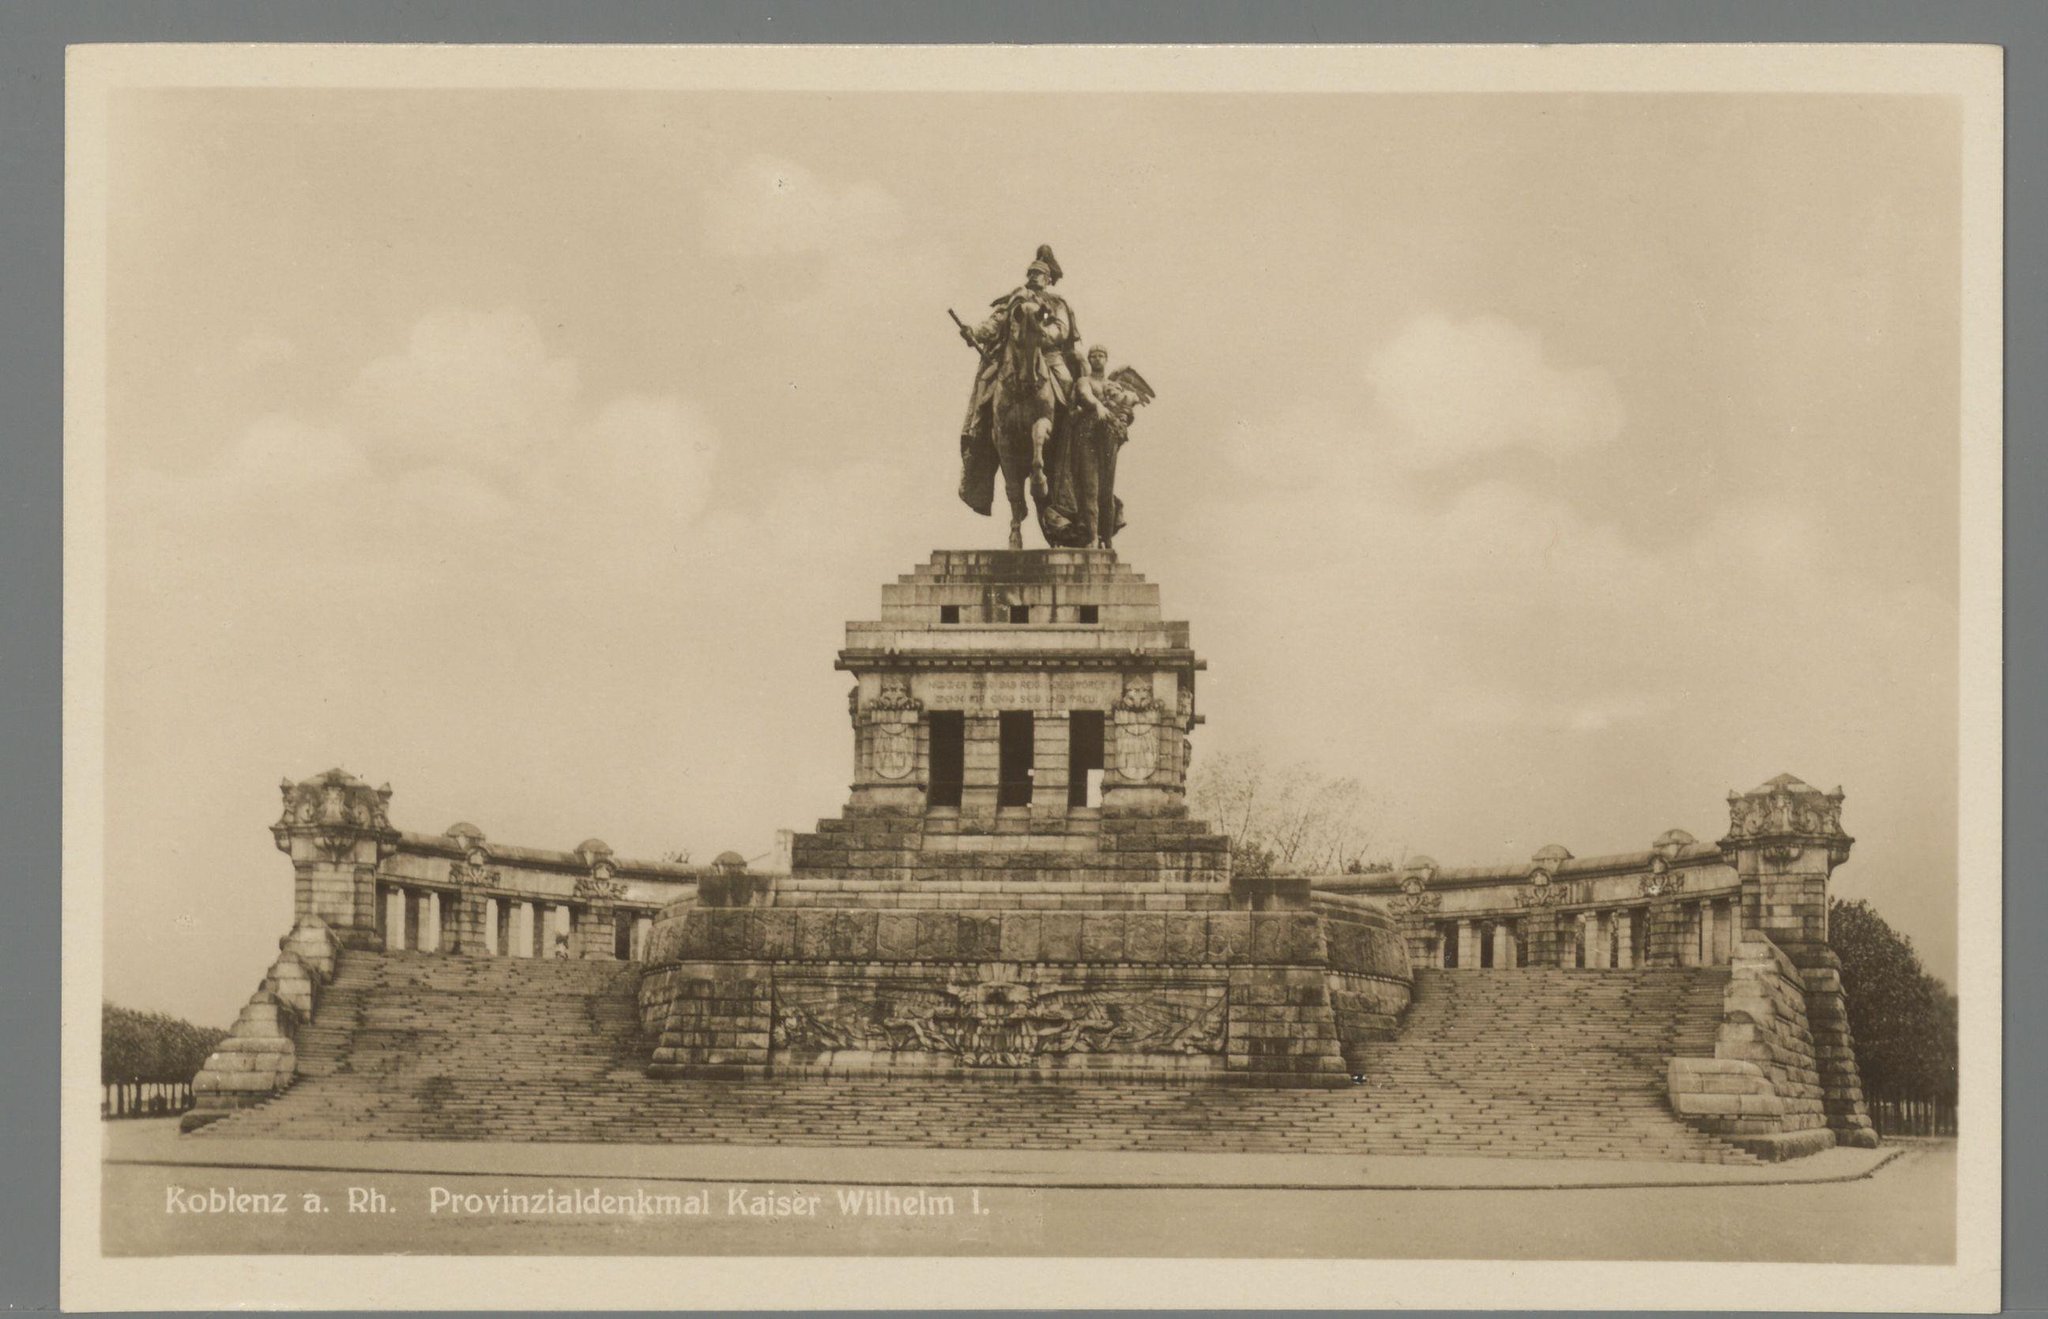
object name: photograph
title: Koblenz a. Rh. Provinzialdenkmal Kaiser Wilhelm I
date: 1905-1930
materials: photographic support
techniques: gelatin silver print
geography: koblenz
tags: berlin, wilhelm i (keizer van duitsland), monument, statue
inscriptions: inscription: ‘V.U.K.’